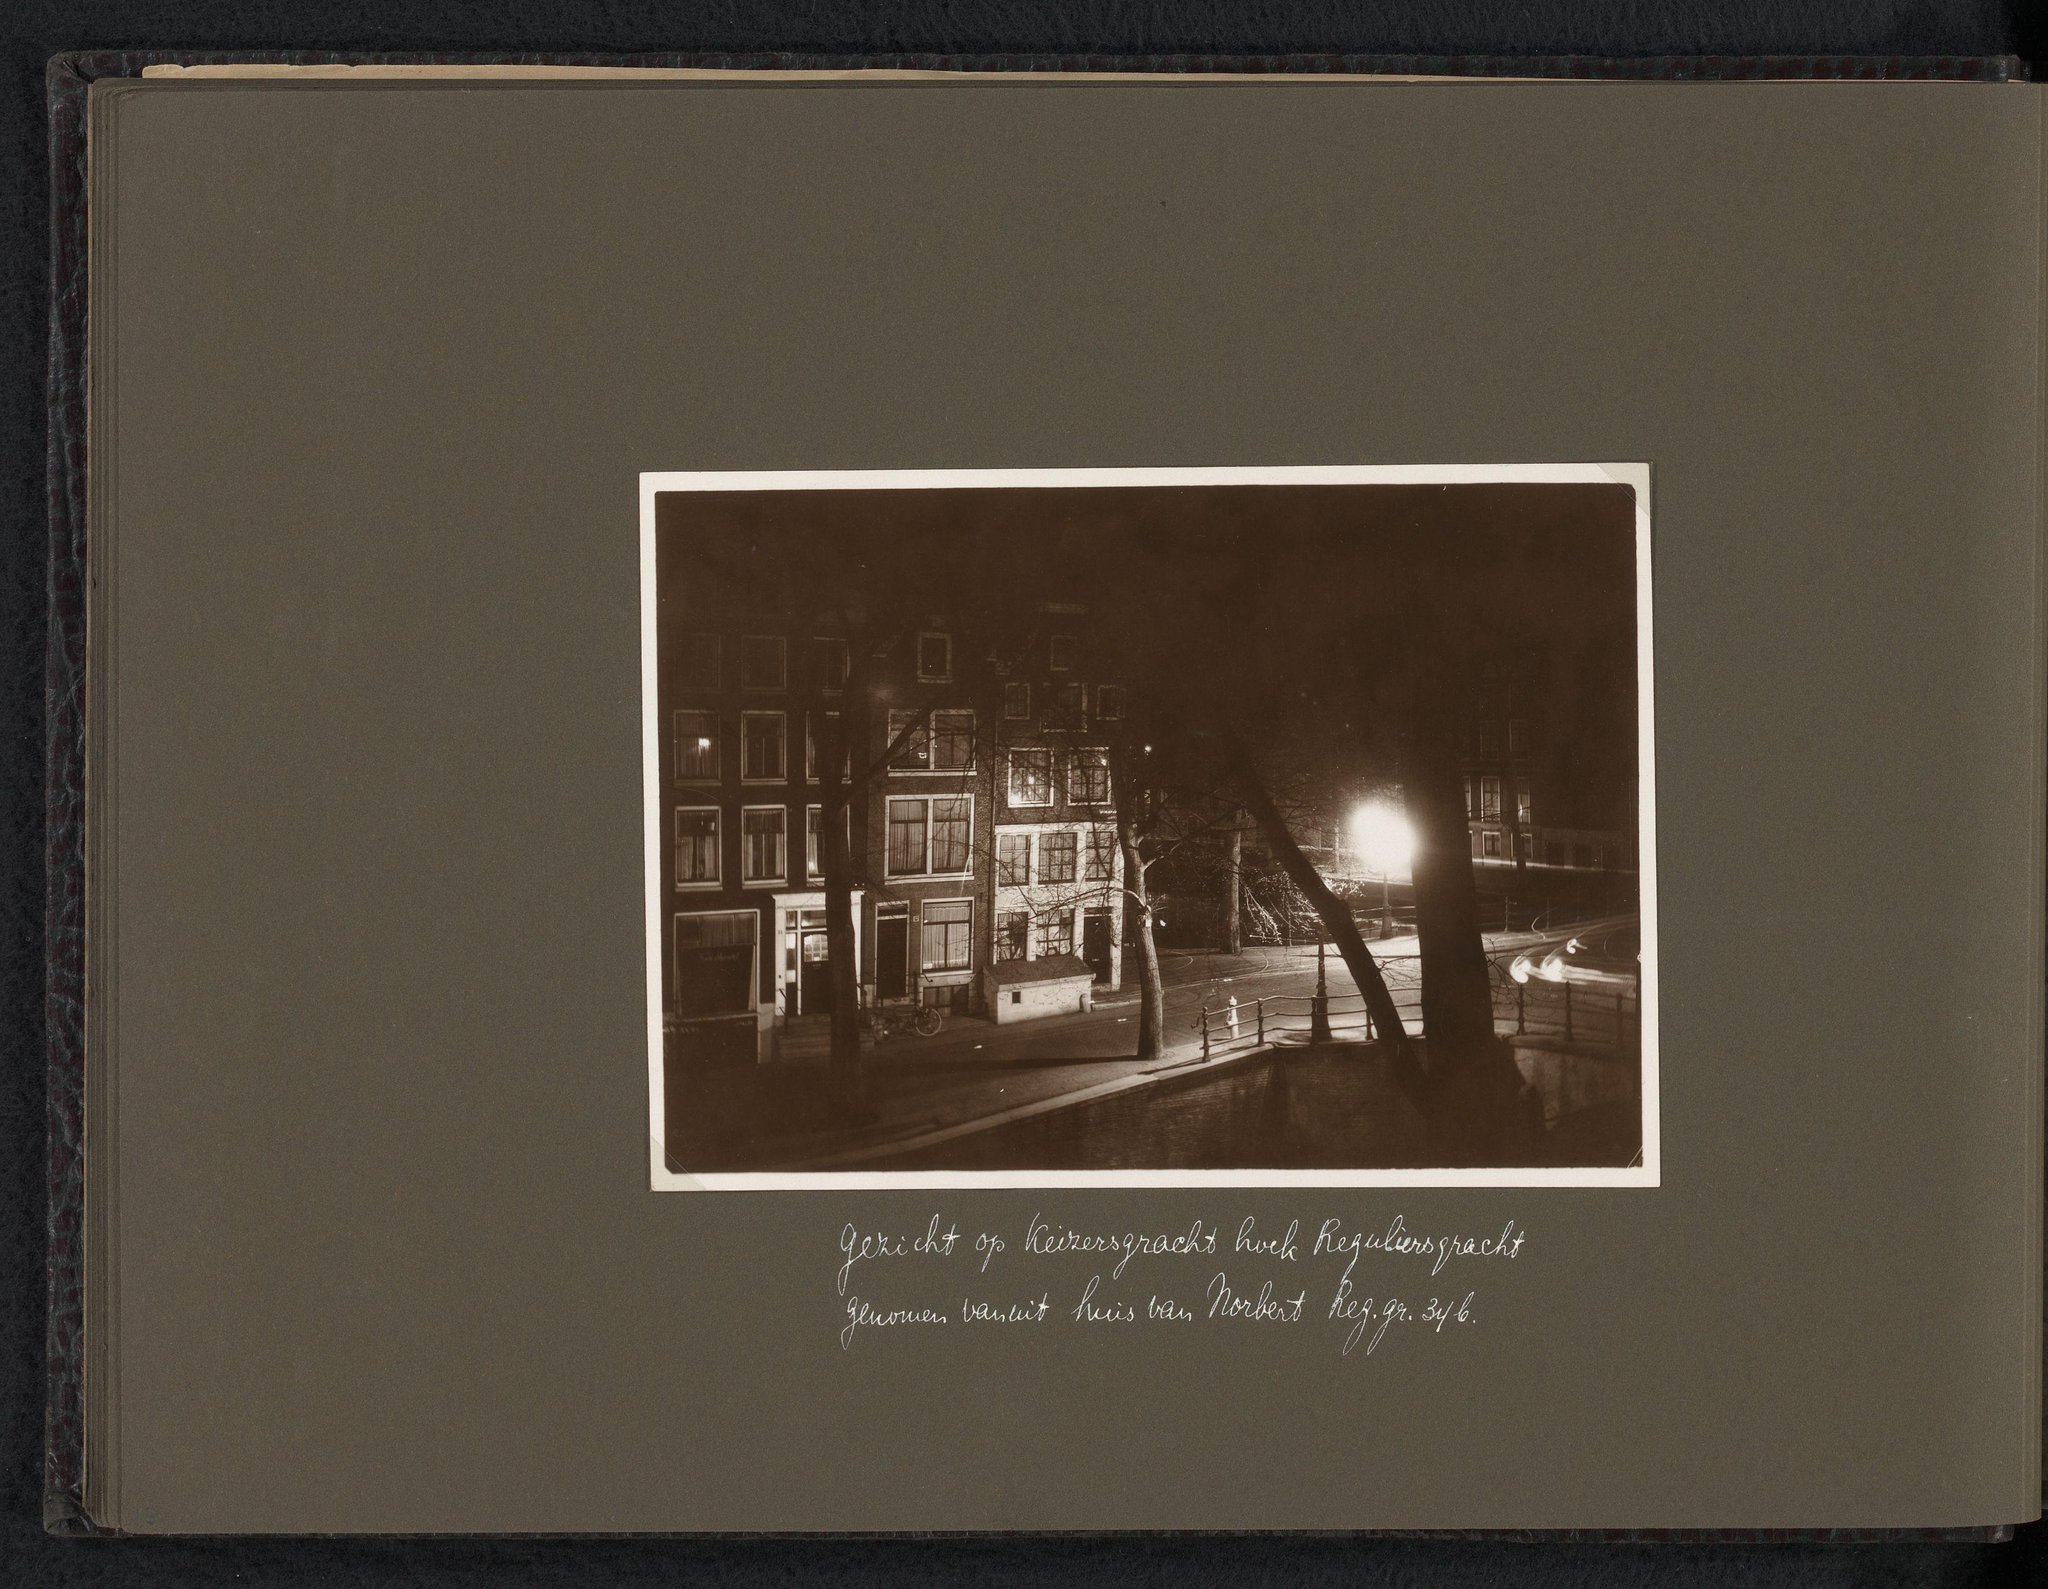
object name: album leaf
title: Gezicht op de hoek van de Keizersgracht en de Reguliersgracht, gezien vanuit het huis van Norbert van den Berg, Amsterdam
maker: frank willem van den berg (1912-1998)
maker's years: 1912-1998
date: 1930-1931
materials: paper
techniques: gelatin silver print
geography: amsterdam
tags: canals, waters (in city)